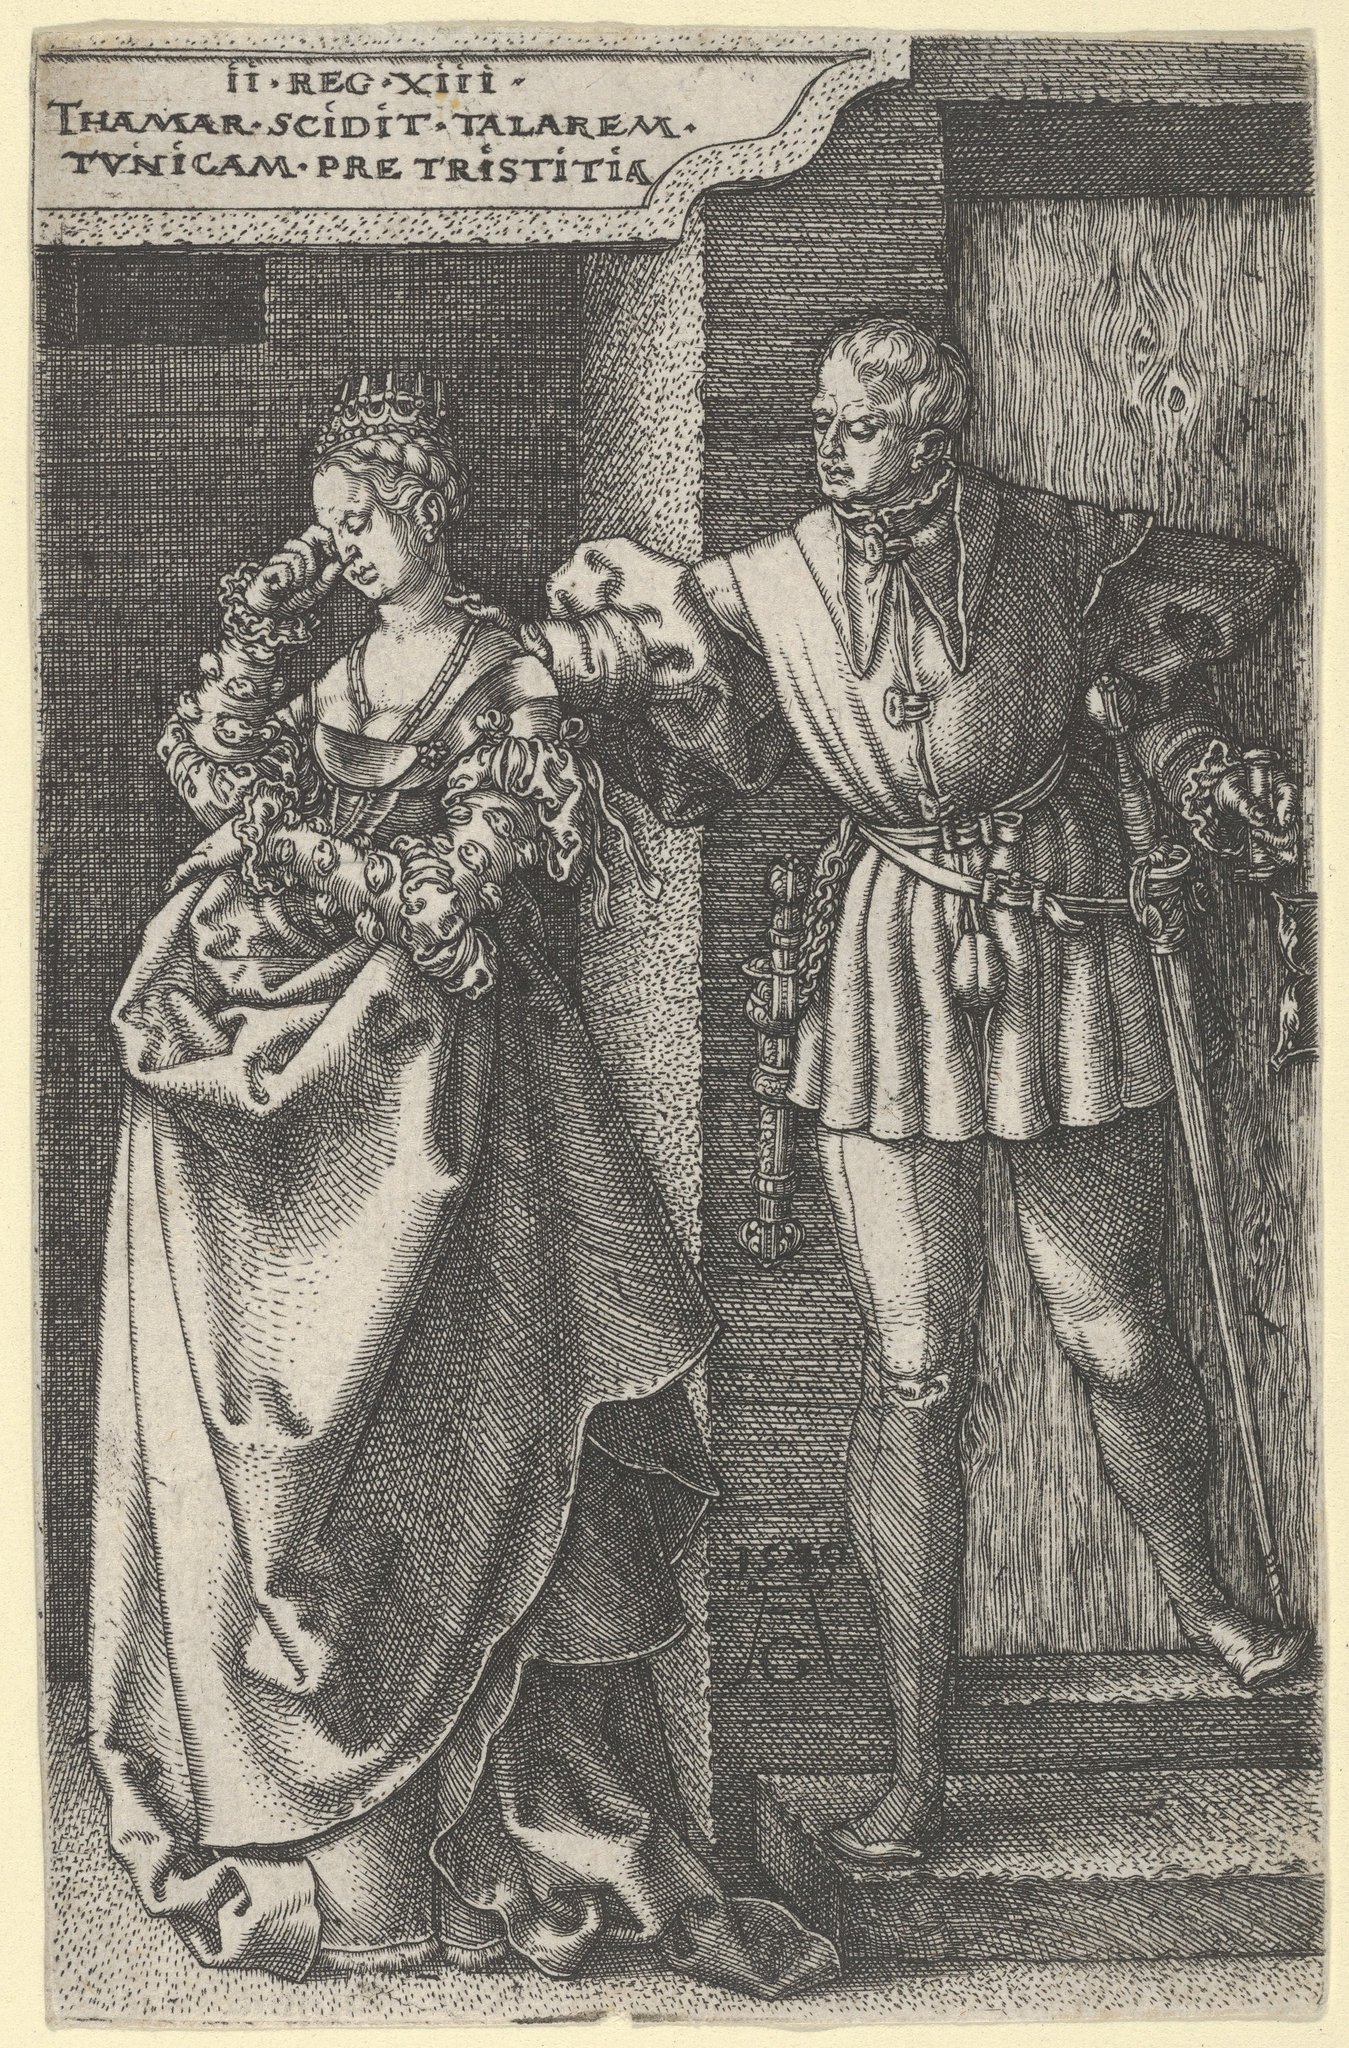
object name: print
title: Tamar Turned Out of Amnon's House, from "The Story of Amnon and Tamar"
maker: heinrich aldegrever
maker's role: artist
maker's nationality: german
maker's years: 1502-1561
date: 1540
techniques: engraving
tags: men,women